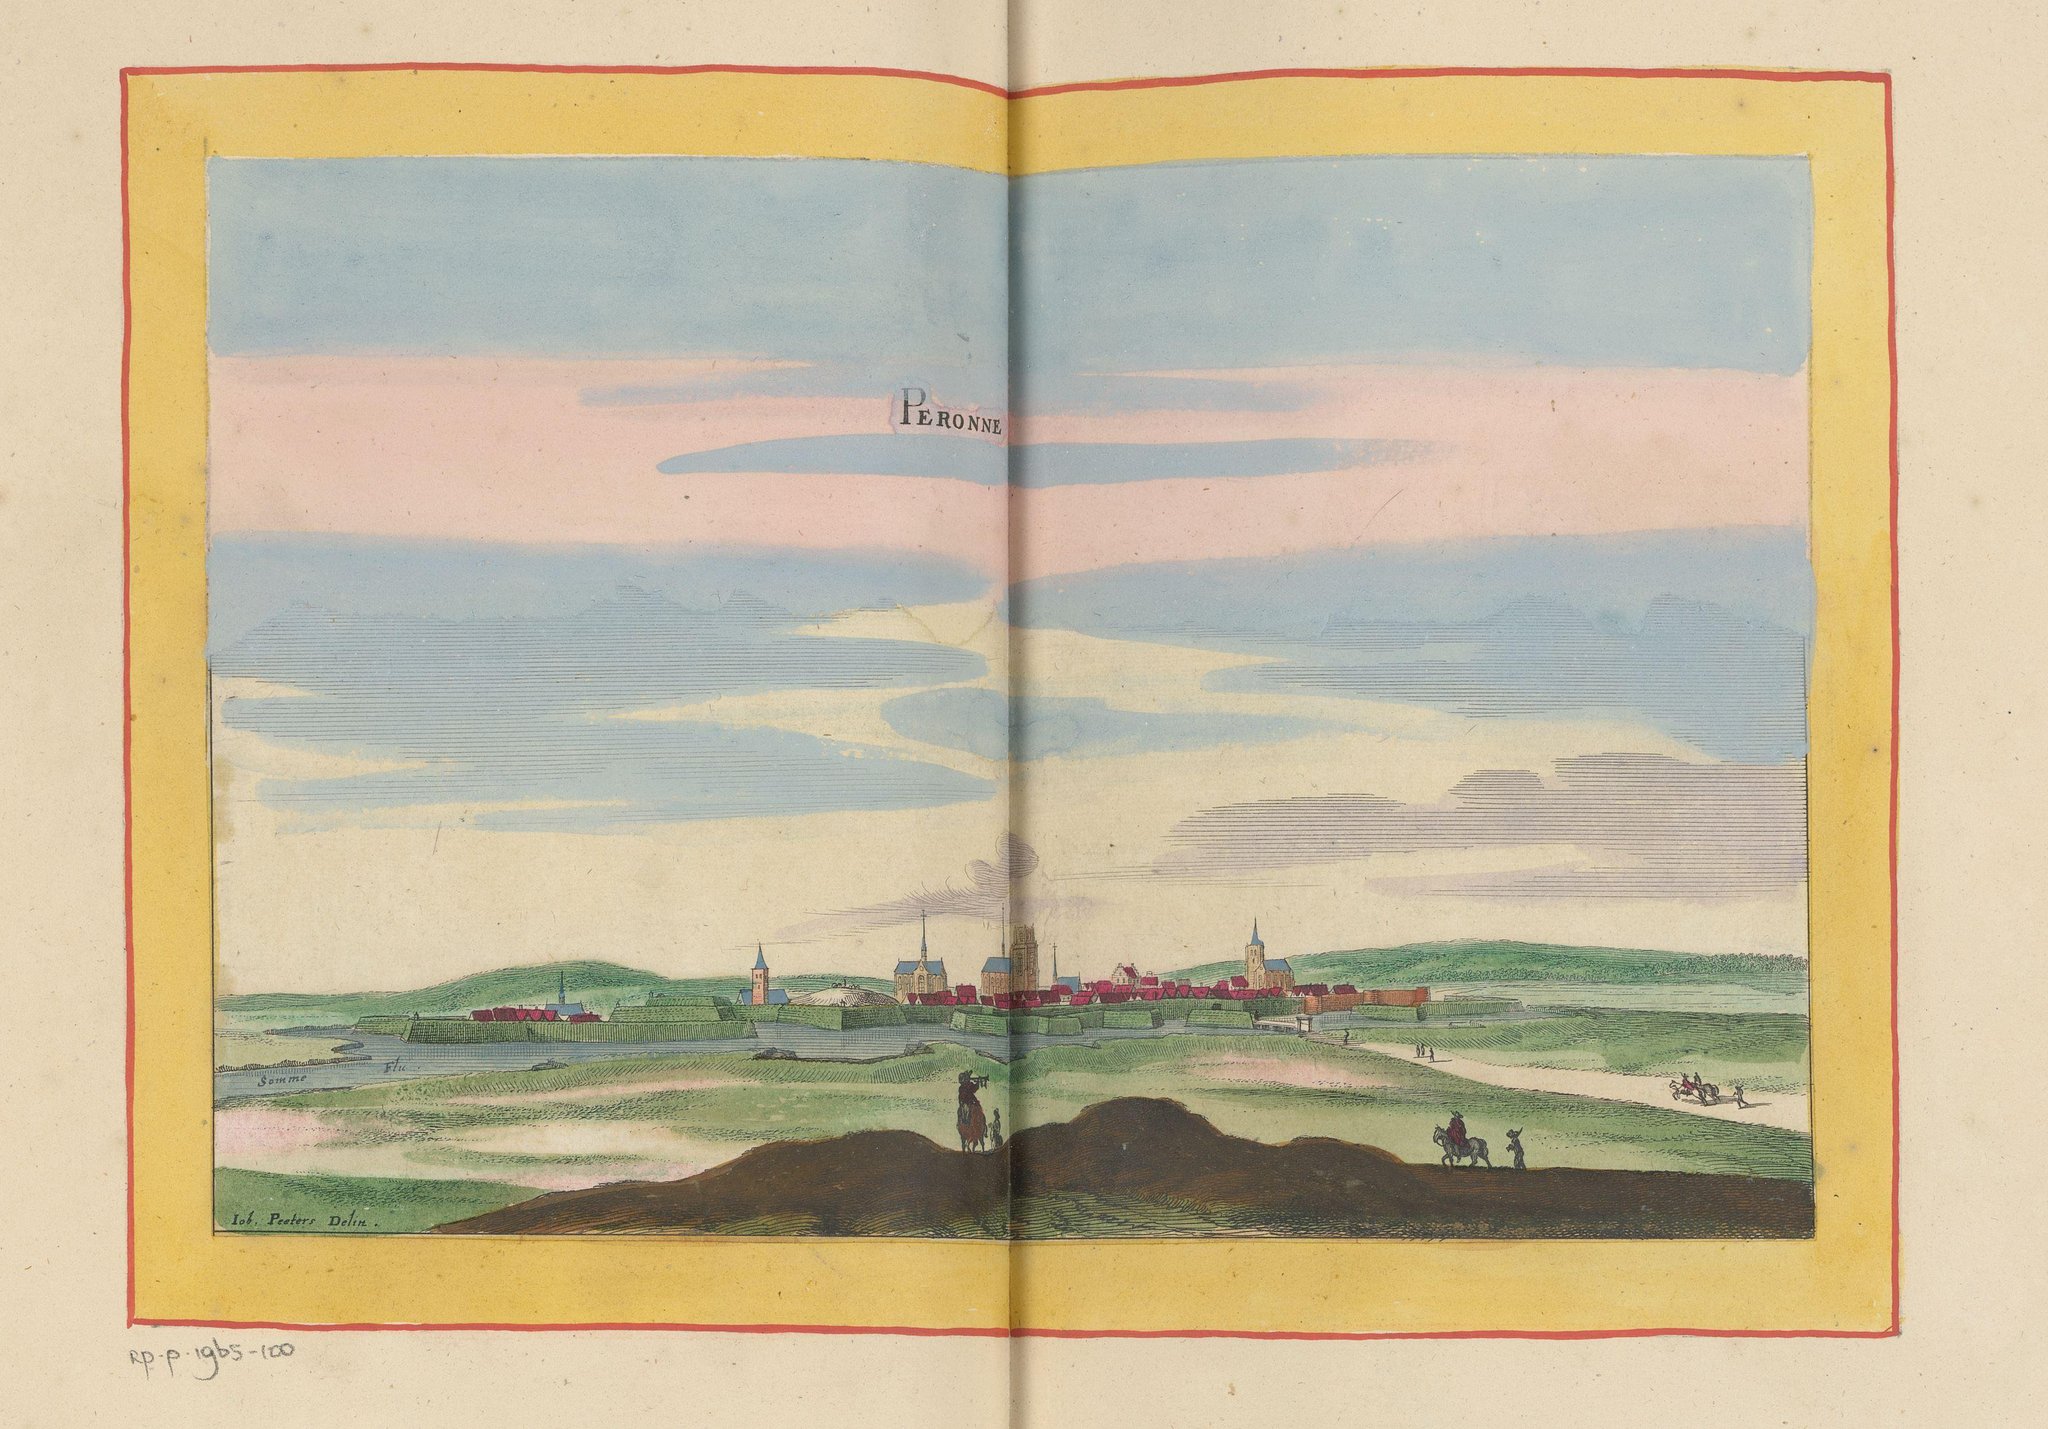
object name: print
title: Peronne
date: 1656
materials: paper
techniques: engraving, etching, hand coloring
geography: frankfurt am main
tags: city-view in general; 'veduta'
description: Prent uit: Zeiller, Martin. Topographia Galliae. 13 dln. Frankfurt: Caspar Merian, 1656, dl. 2, na p. 264. De titel is uit de originele prent gesneden. Boven de gravure is een deel lucht en wolken (bij)geschilderd, waarin de titel gelijmd is. Origineel van één plaat gedrukt met het gezicht op Saint-Quentin (P-1956-101).